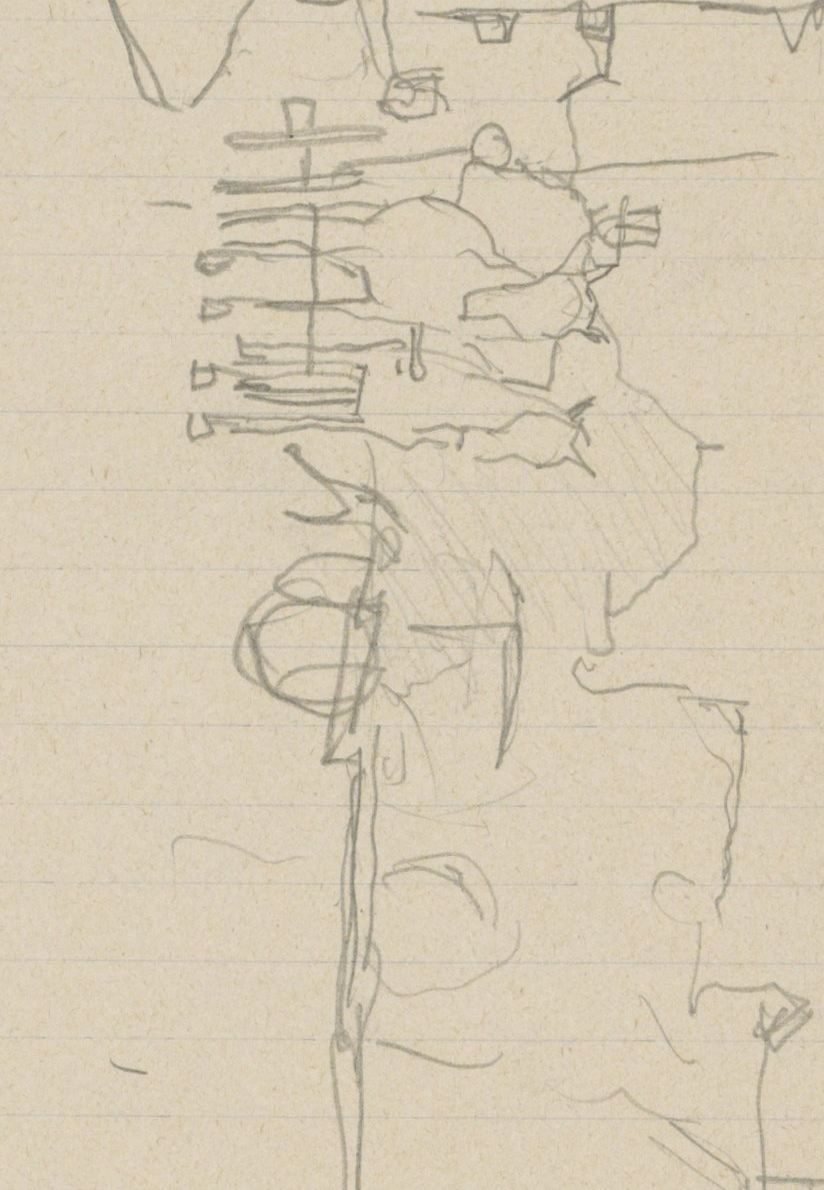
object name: sketchbook leaf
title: Gezicht op het Rokin in Amsterdam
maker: george hendrik breitner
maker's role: draughtsman, painter, print maker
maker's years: 1857-1923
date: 1903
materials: pencil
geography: amsterdam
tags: four-wheeled, animal-drawn vehicle, e.g.: cab, carriage, coach, horse, civic architecture; edifices; dwellings, (farm) wagon, freight wagon, cart, street (+ city(-scape) with figures, staffage)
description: Vooraan een paardenkar en een rijtuig. Pagina 56 uit een schetsboek met 32 bladen.